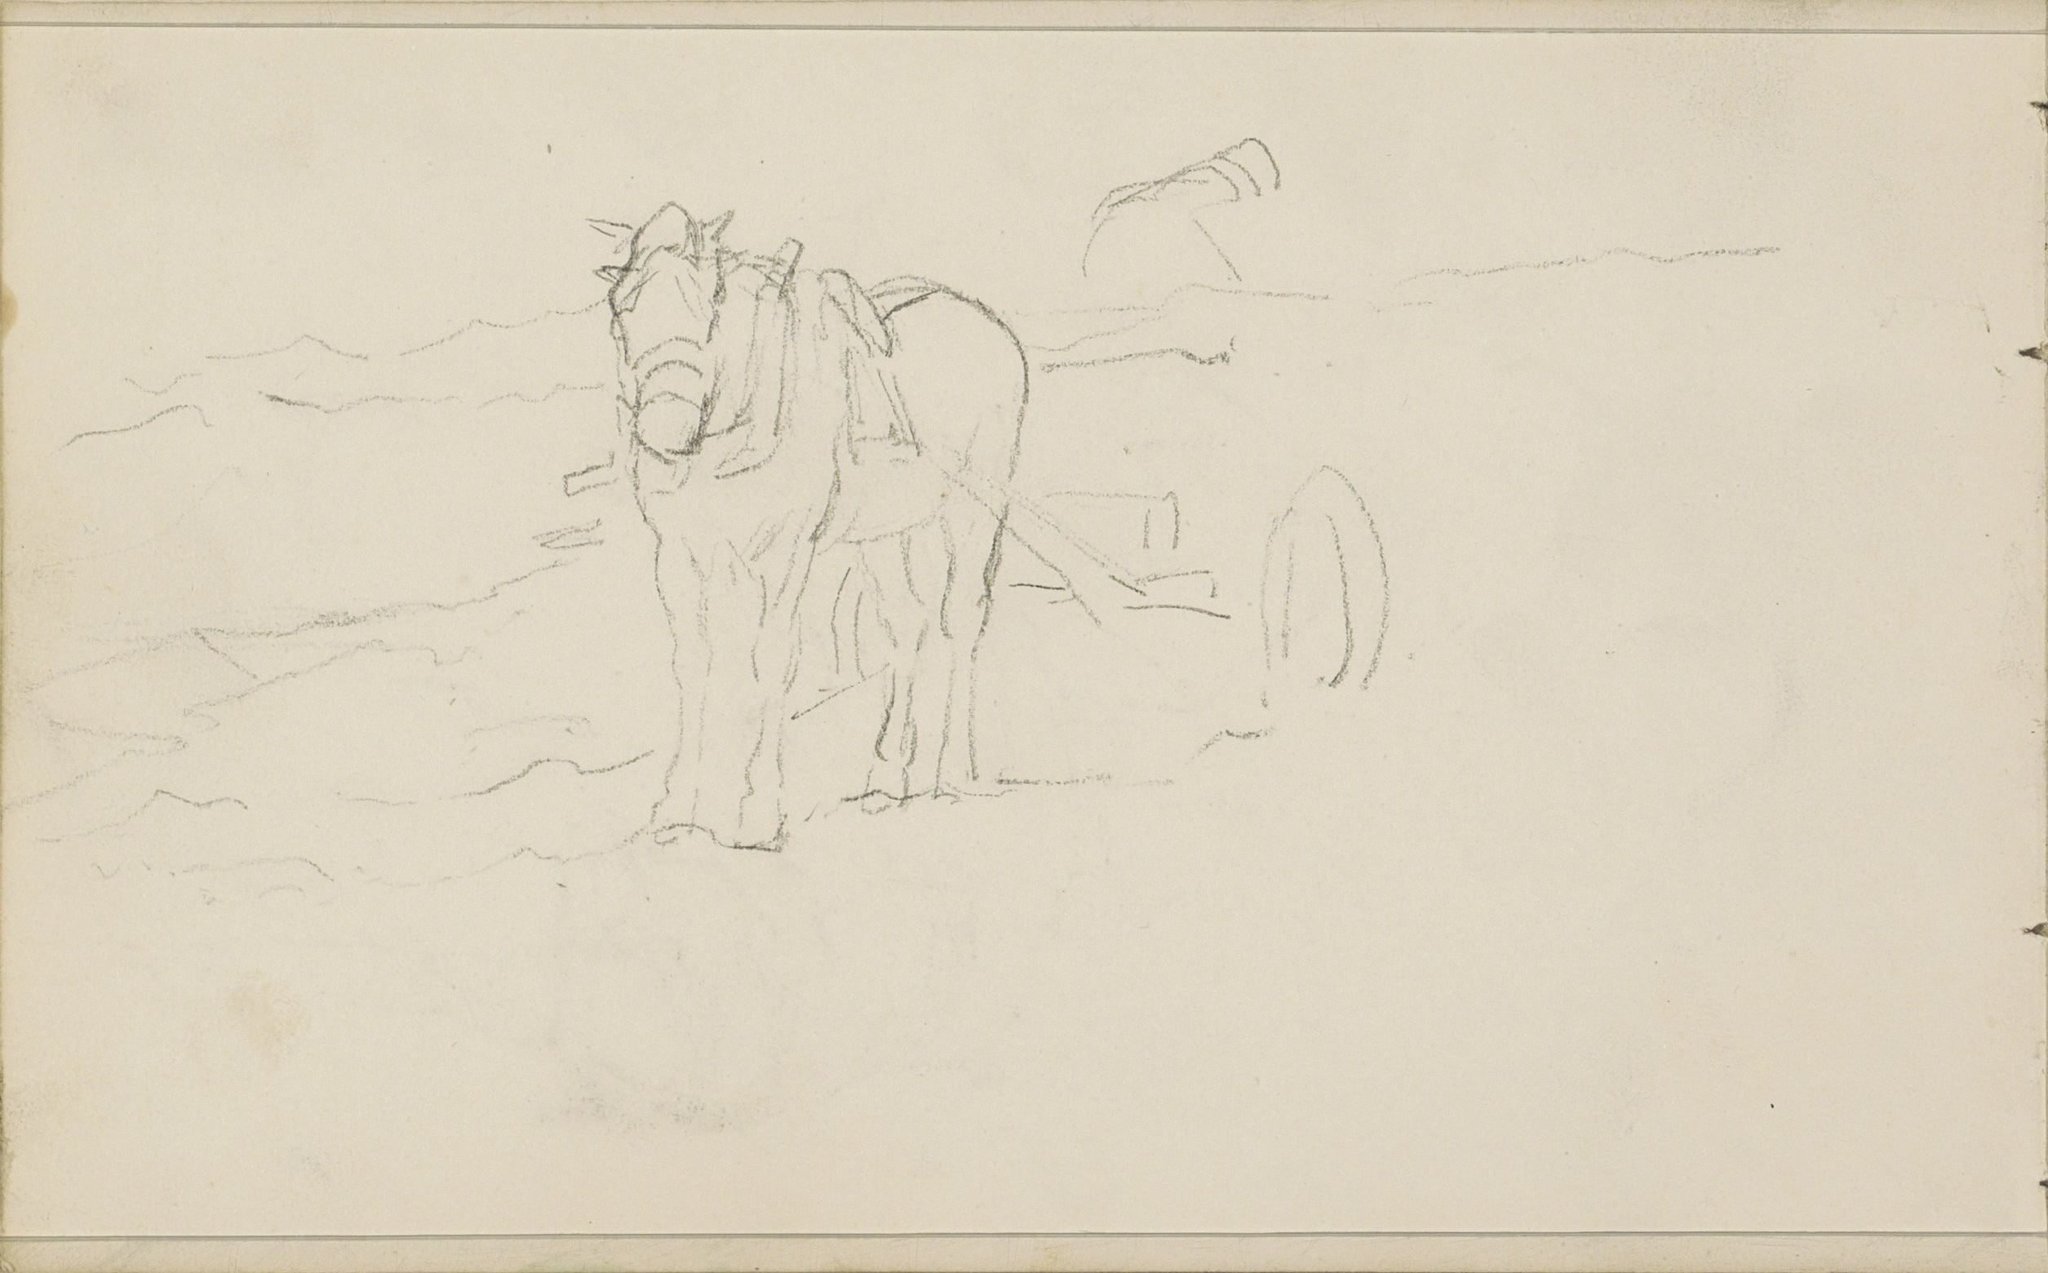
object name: sketchbook leaf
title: Ploegend paard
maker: anton mauve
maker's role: draughtsman, painter, print maker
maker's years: 1838-1888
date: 1848-1888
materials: paper, pencil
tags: horse, ploughing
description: Blad 12 verso uit een schetsboek met 42 bladen.